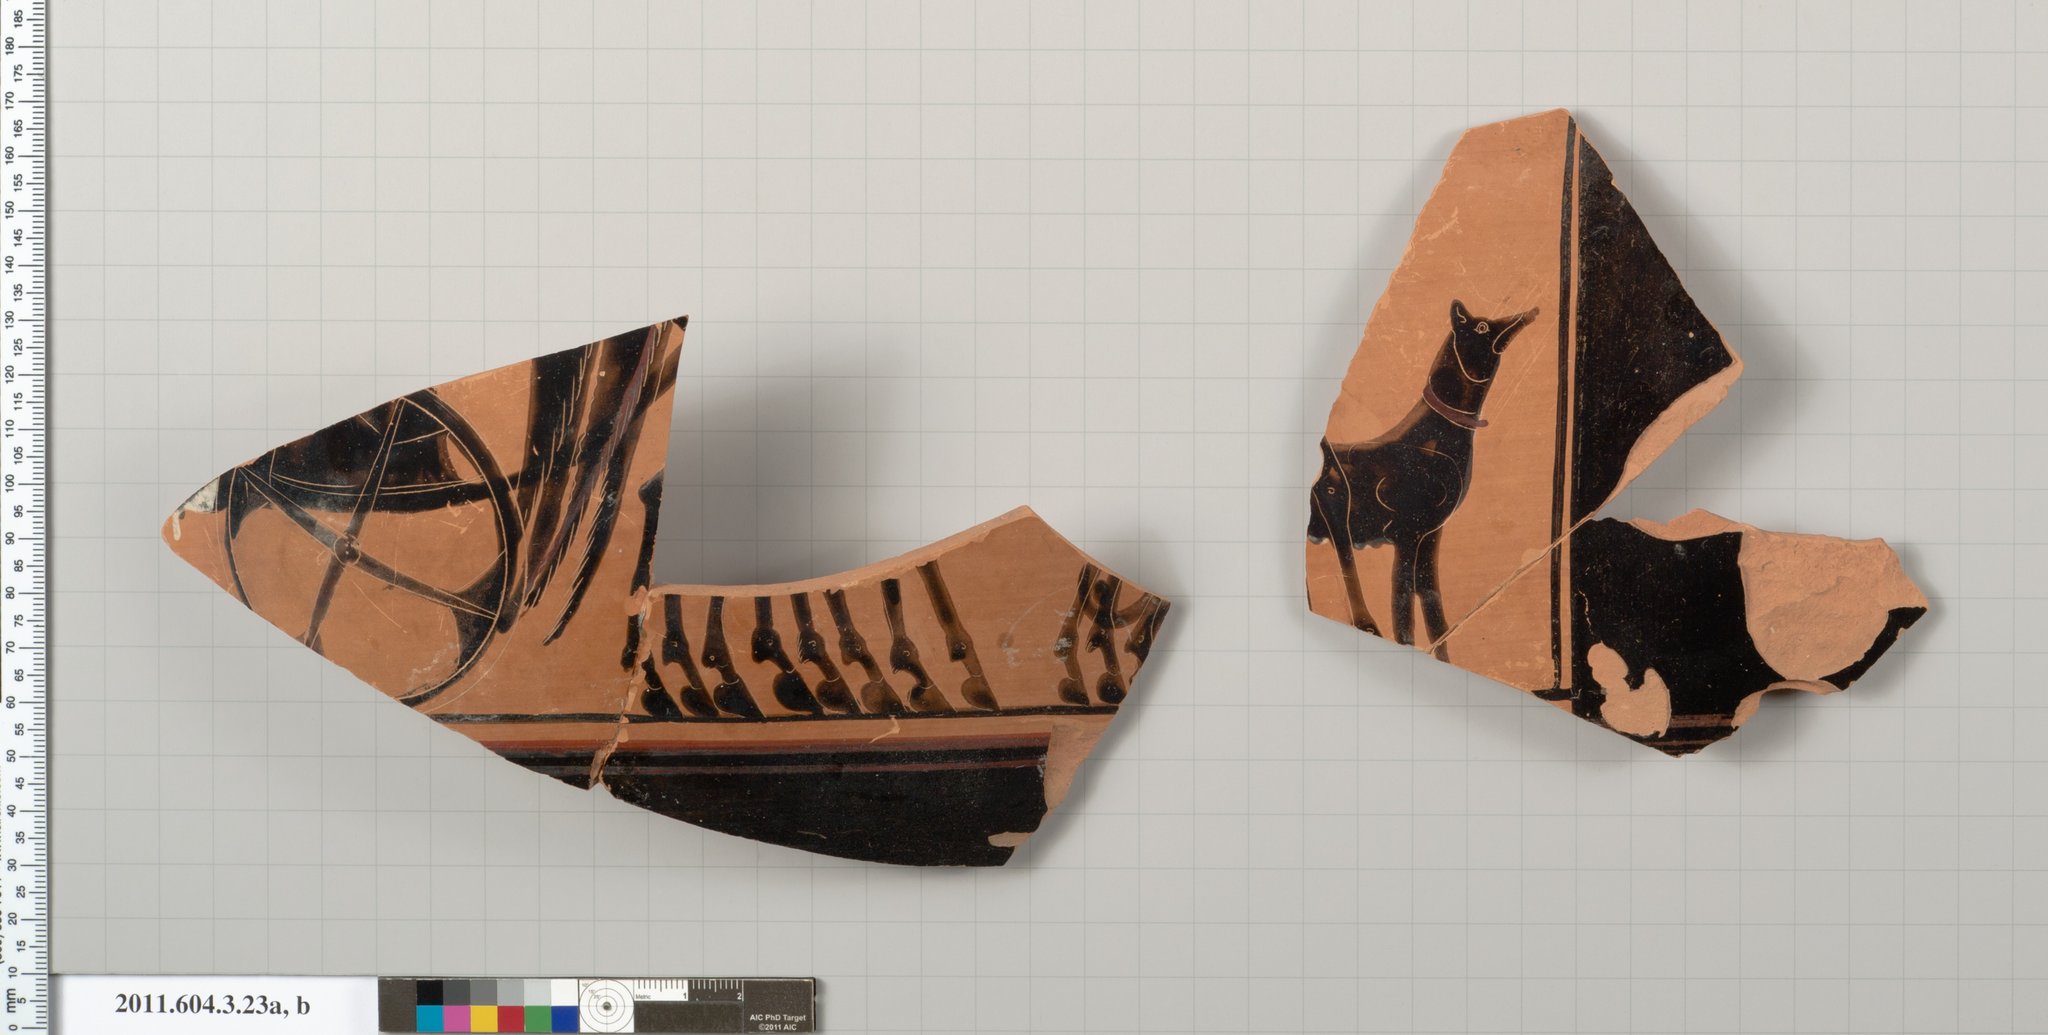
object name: amphora fragment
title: Terracotta fragments of an amphora (jar)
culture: greek, attic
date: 530-520 BCE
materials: terracotta